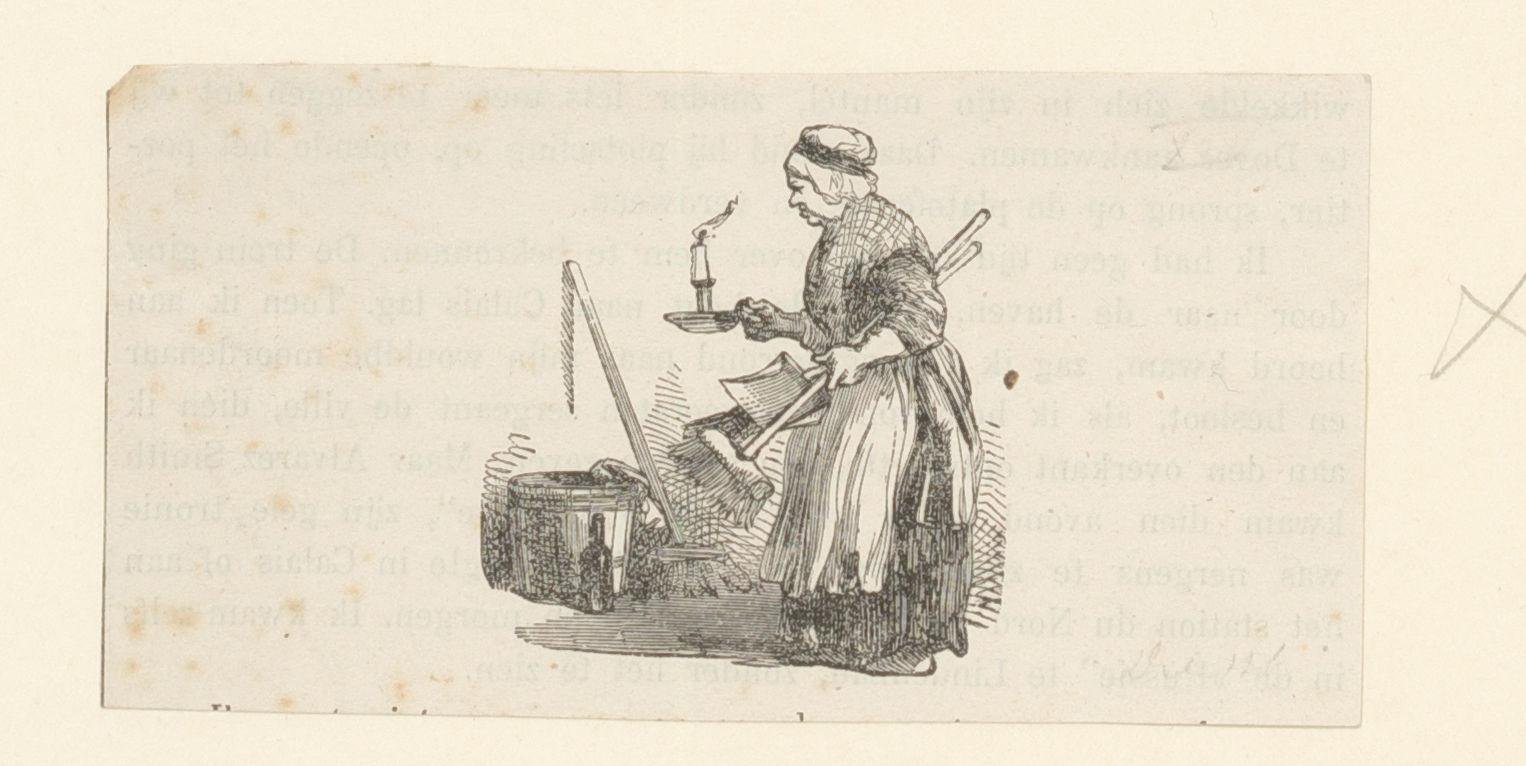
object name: print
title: Dienstbode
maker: Anonymous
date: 1875-1900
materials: paper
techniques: engraving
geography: netherlands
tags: maid ~ house personnel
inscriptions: collector's mark: Lugt 1641, collector's mark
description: Een oude dienstbode met in haar rechter hand een blaker en onder haar linker arm een bezem, veger en blik. Bedrukt op de achterzijde met tekst. Onderwerpsrubrieken binnen de Atlas Zeden en Gewoonten: Beroep en bedrijf. Vrouwelijk beroep en bedrijf. Dienstboden.